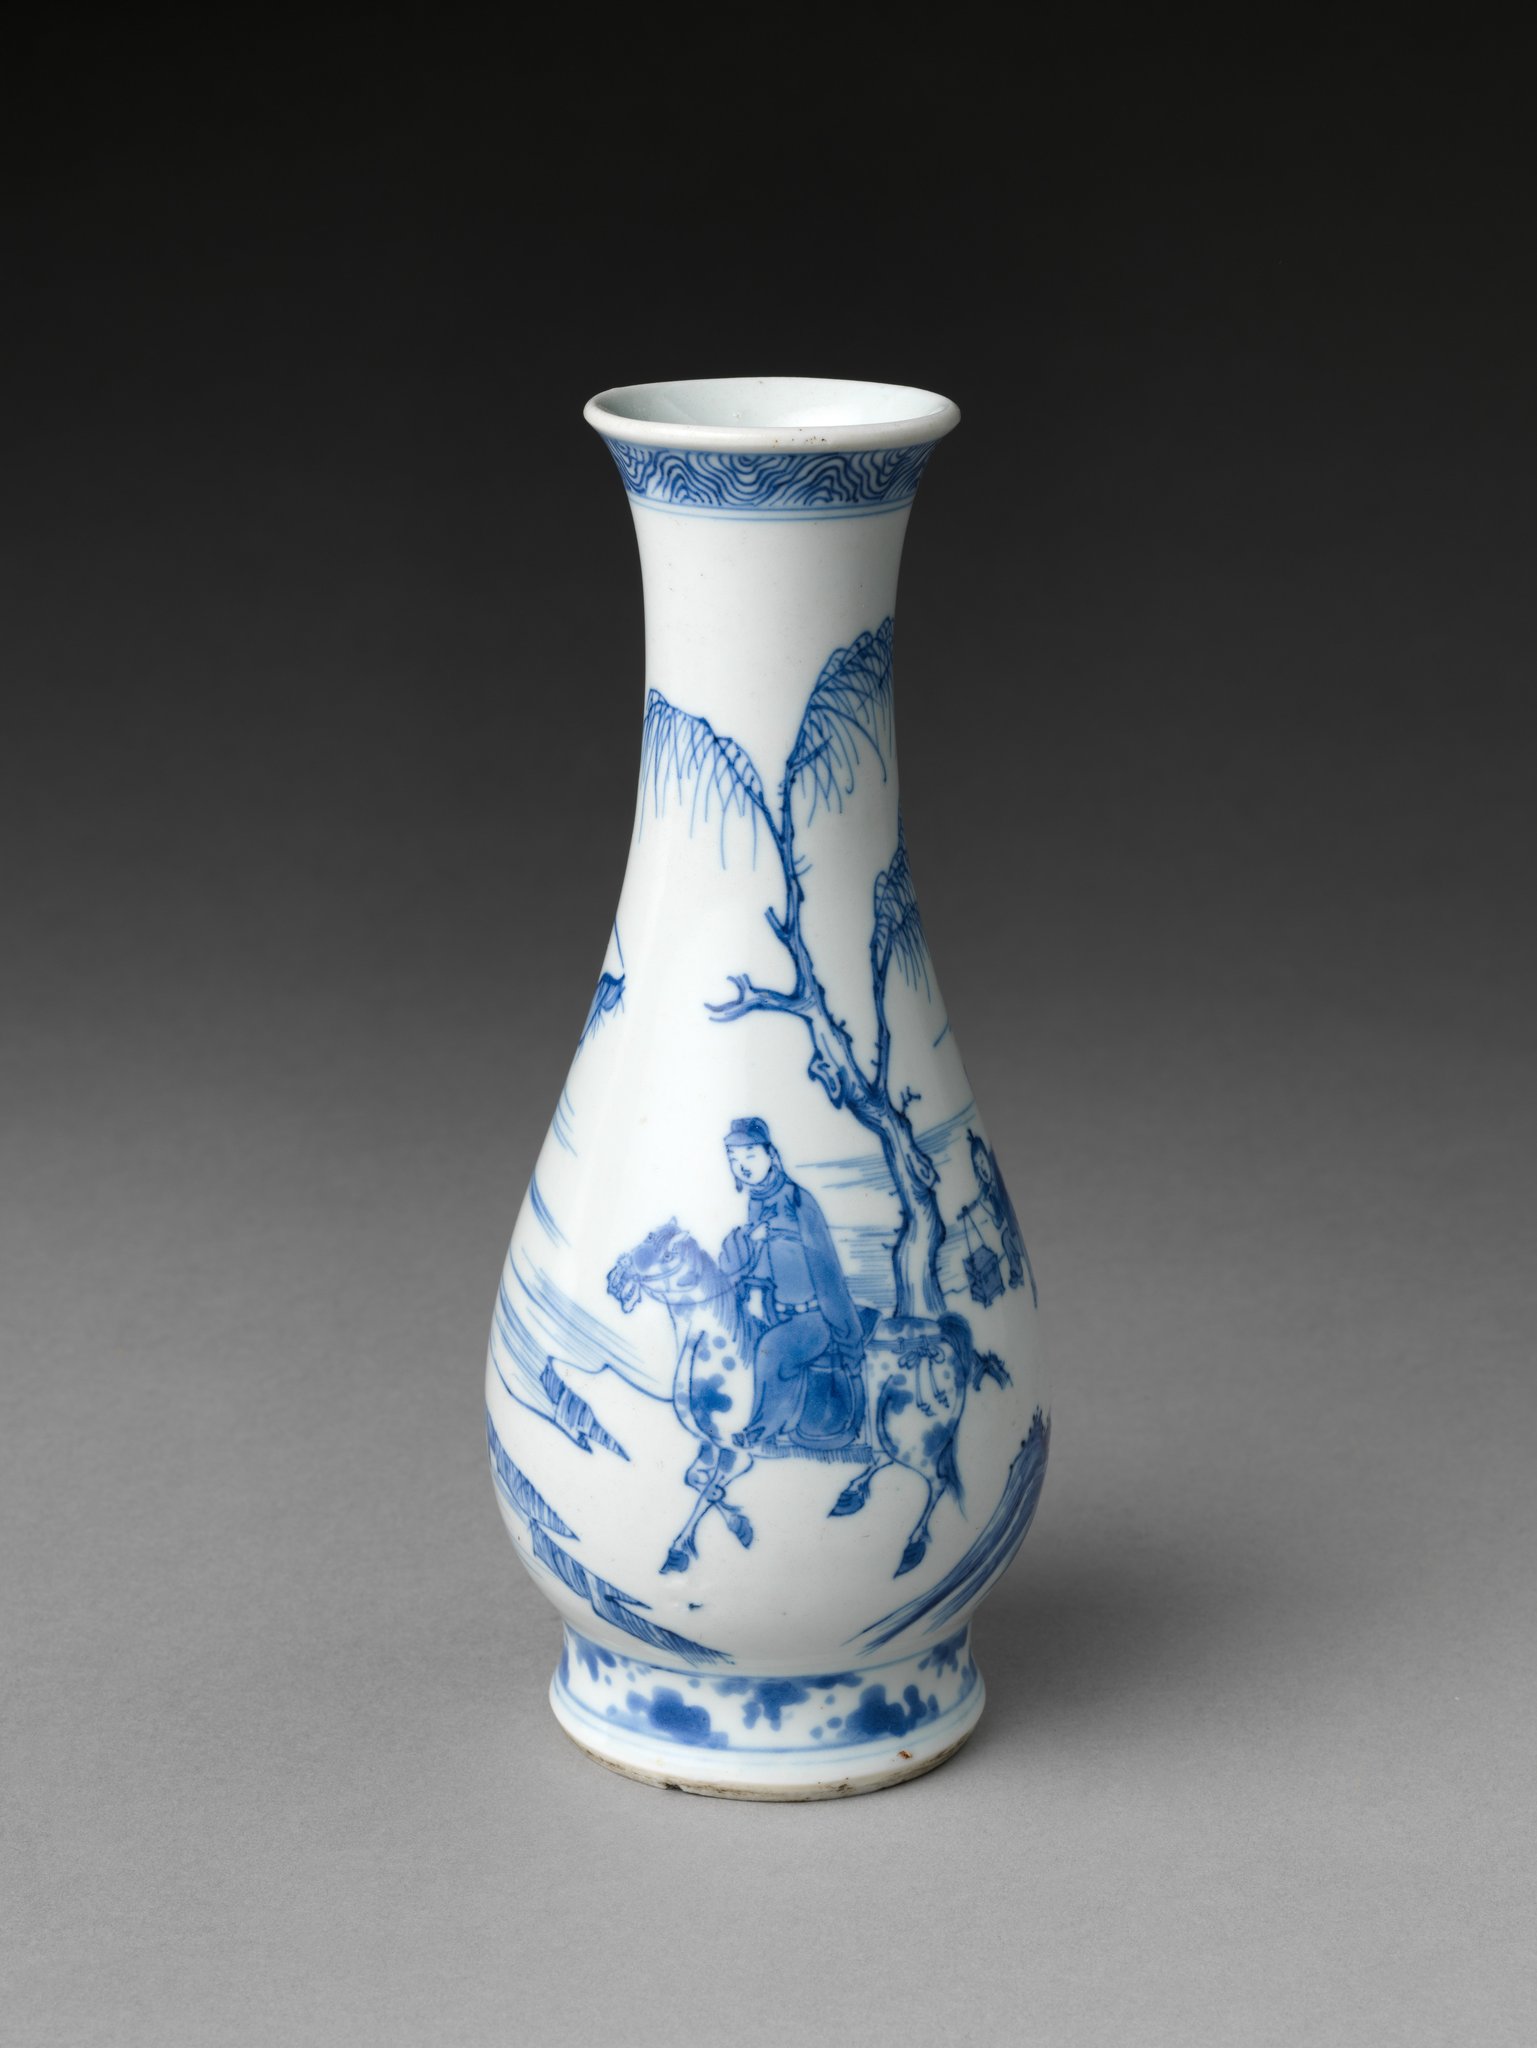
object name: vase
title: Vase with equestrian figure in landscape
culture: chinese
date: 1634-1666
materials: cobalt, porcelain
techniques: painting, underglaze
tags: horses,trees